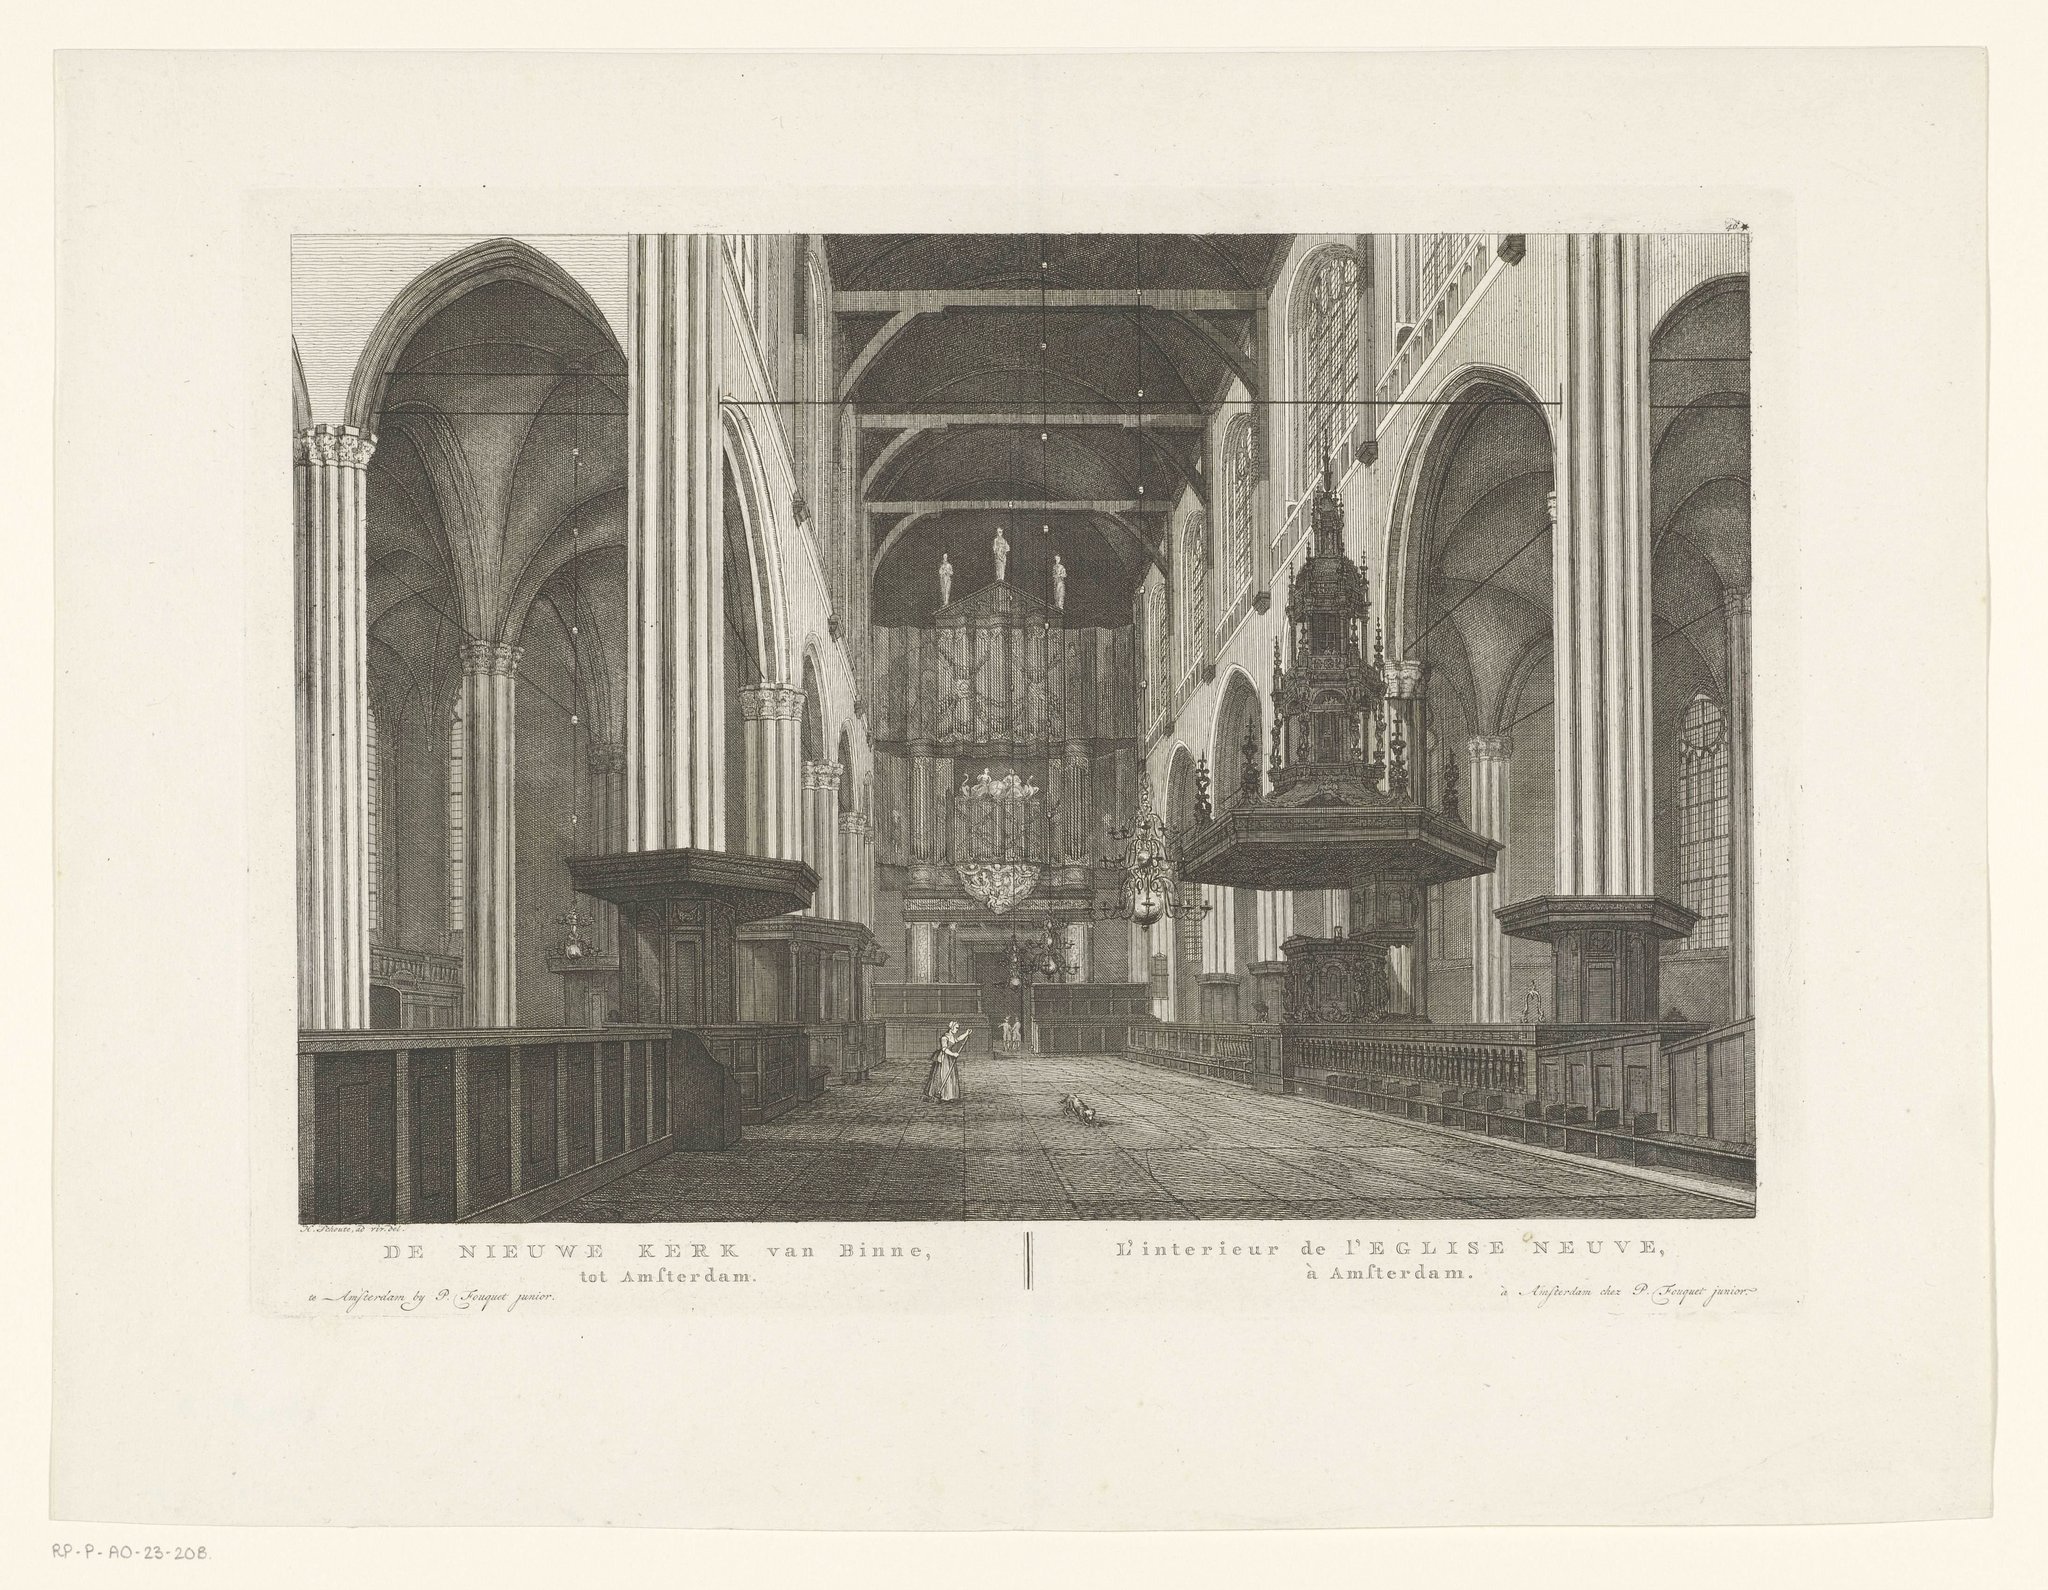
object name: print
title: De Nieuwe Kerk van Binne, tot Amsterdam / L'interieur de l'Eglise Neuve, à Amsterdam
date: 1770-1783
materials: paper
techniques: engraving, etching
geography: amsterdam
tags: interior of church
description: Deze prent is ook gebruikt in de zogenaamde Atlas van Fouquet.* Pierre Fouquet gaf vanaf 1760 stadsgezichten van Amsterdam - naar tekeningen van verschillende kunstenaars, gemaakt door verschillende prentmakers - uit. Deze prenten werden aanvankelijk los of in series verkocht. Zoals toen gebruikelijk kon de koper de prenten zelf laten inbinden. Hiertoe gaf Fouquet tussen 1778 en 1783 een titelblad, plattegrond en inhoudsopgave van de tot dusver 100 uitgegeven prenten uit (1). Gezien de inhoud afhankelijk was van wat de koper had verzameld verschilt de inhoud van de verschillende bewaarde Fouquetatlassen onder deze titel sterk. Ook zijn er exemplaren bekend waar tevens andere prenten aan zijn toegevoegd. Omdat er behoefte bleek aan uitleg bij de platen werd in 1783 een nieuwe versie van de atlas uitgegeven, aangevuld met tekst en twee prenten. De aangegeven volgorde veranderde maar de platen van de al eerder uitgegeven prenten bleven ongewijzigd. Deze uitgave werd in opdracht van Fouquet gedrukt bij Daniël Jean Changuion en Petrus den Hengst (2). Een tiental platen werd bijgewerkt en verscheen, met nieuw impressum, in het vervolg van Wagenaars geschiedenis van Amsterdam, uitgeven door Petrus Conradi en Folkert van der Plaats (3). Een aantal jaar na het overlijden van Fouquet kwam Evert Maaskamp met een nieuwe uitgave van de atlas, met verbeterde tekst en toevoeging van twee prenten. Op alle platen verwijderde hij het oude en liet hij zijn eigen impressum zetten (4). De huidige staat van de prent komt voor in exemplaren van de onder (1) en (2) genoemde werken. * Onder de Atlas van Fouquet of Fouquetatlas verstaan we de hieronder vermelde publicaties (1), (2) en (4). (1). Afbeeldingen van de wyd-vermaarde koopstad Amsterdam benevens des zelvs voornaamste gebouwen en gezigten alle naar het leeven getekend / Receuil des edifices les plus considerables et des plus belles vues, de la fameuse ville d'Amsterdam, dessinées d'après nature. Amsterdam: Pierre Fouquet, 1778-1783. (2). Nieuwe atlas, van de voornaamste gebouwen en gezigten der stad Amsterdam, met derzelver beknopte beschryvingen. 2 delen. Amsterdam: Daniël Jean Changuion en Petrus den Hengst [in opdracht van Pierre Fouquet], 1783. (3). Stijl, Simon. Amsterdam, in zyne geschiedenissen, voorregten, koophandel, gebouwen, kerkenstaat, schoolen, schutterye, gilden en regeeringe, beschreeven. Om te dienen ten vervolge op het werk van Jan Wagenaar (…). 10 delen. Amsterdam en Harlingen: Petrus Conradi en Folkert van der Plaats, 1788-1801. (4). Nieuwe atlas, van de voornaamste gebouwen en gezigten der stad Amsterdam. Met derzelver beknopte beschryvingen. Amsterdam: Evert Maaskamp, 1805. * Het aantal vermelde staten is gebaseerd op het aantal gevonden staten. Mogelijk zijn er meer staten van deze prent.